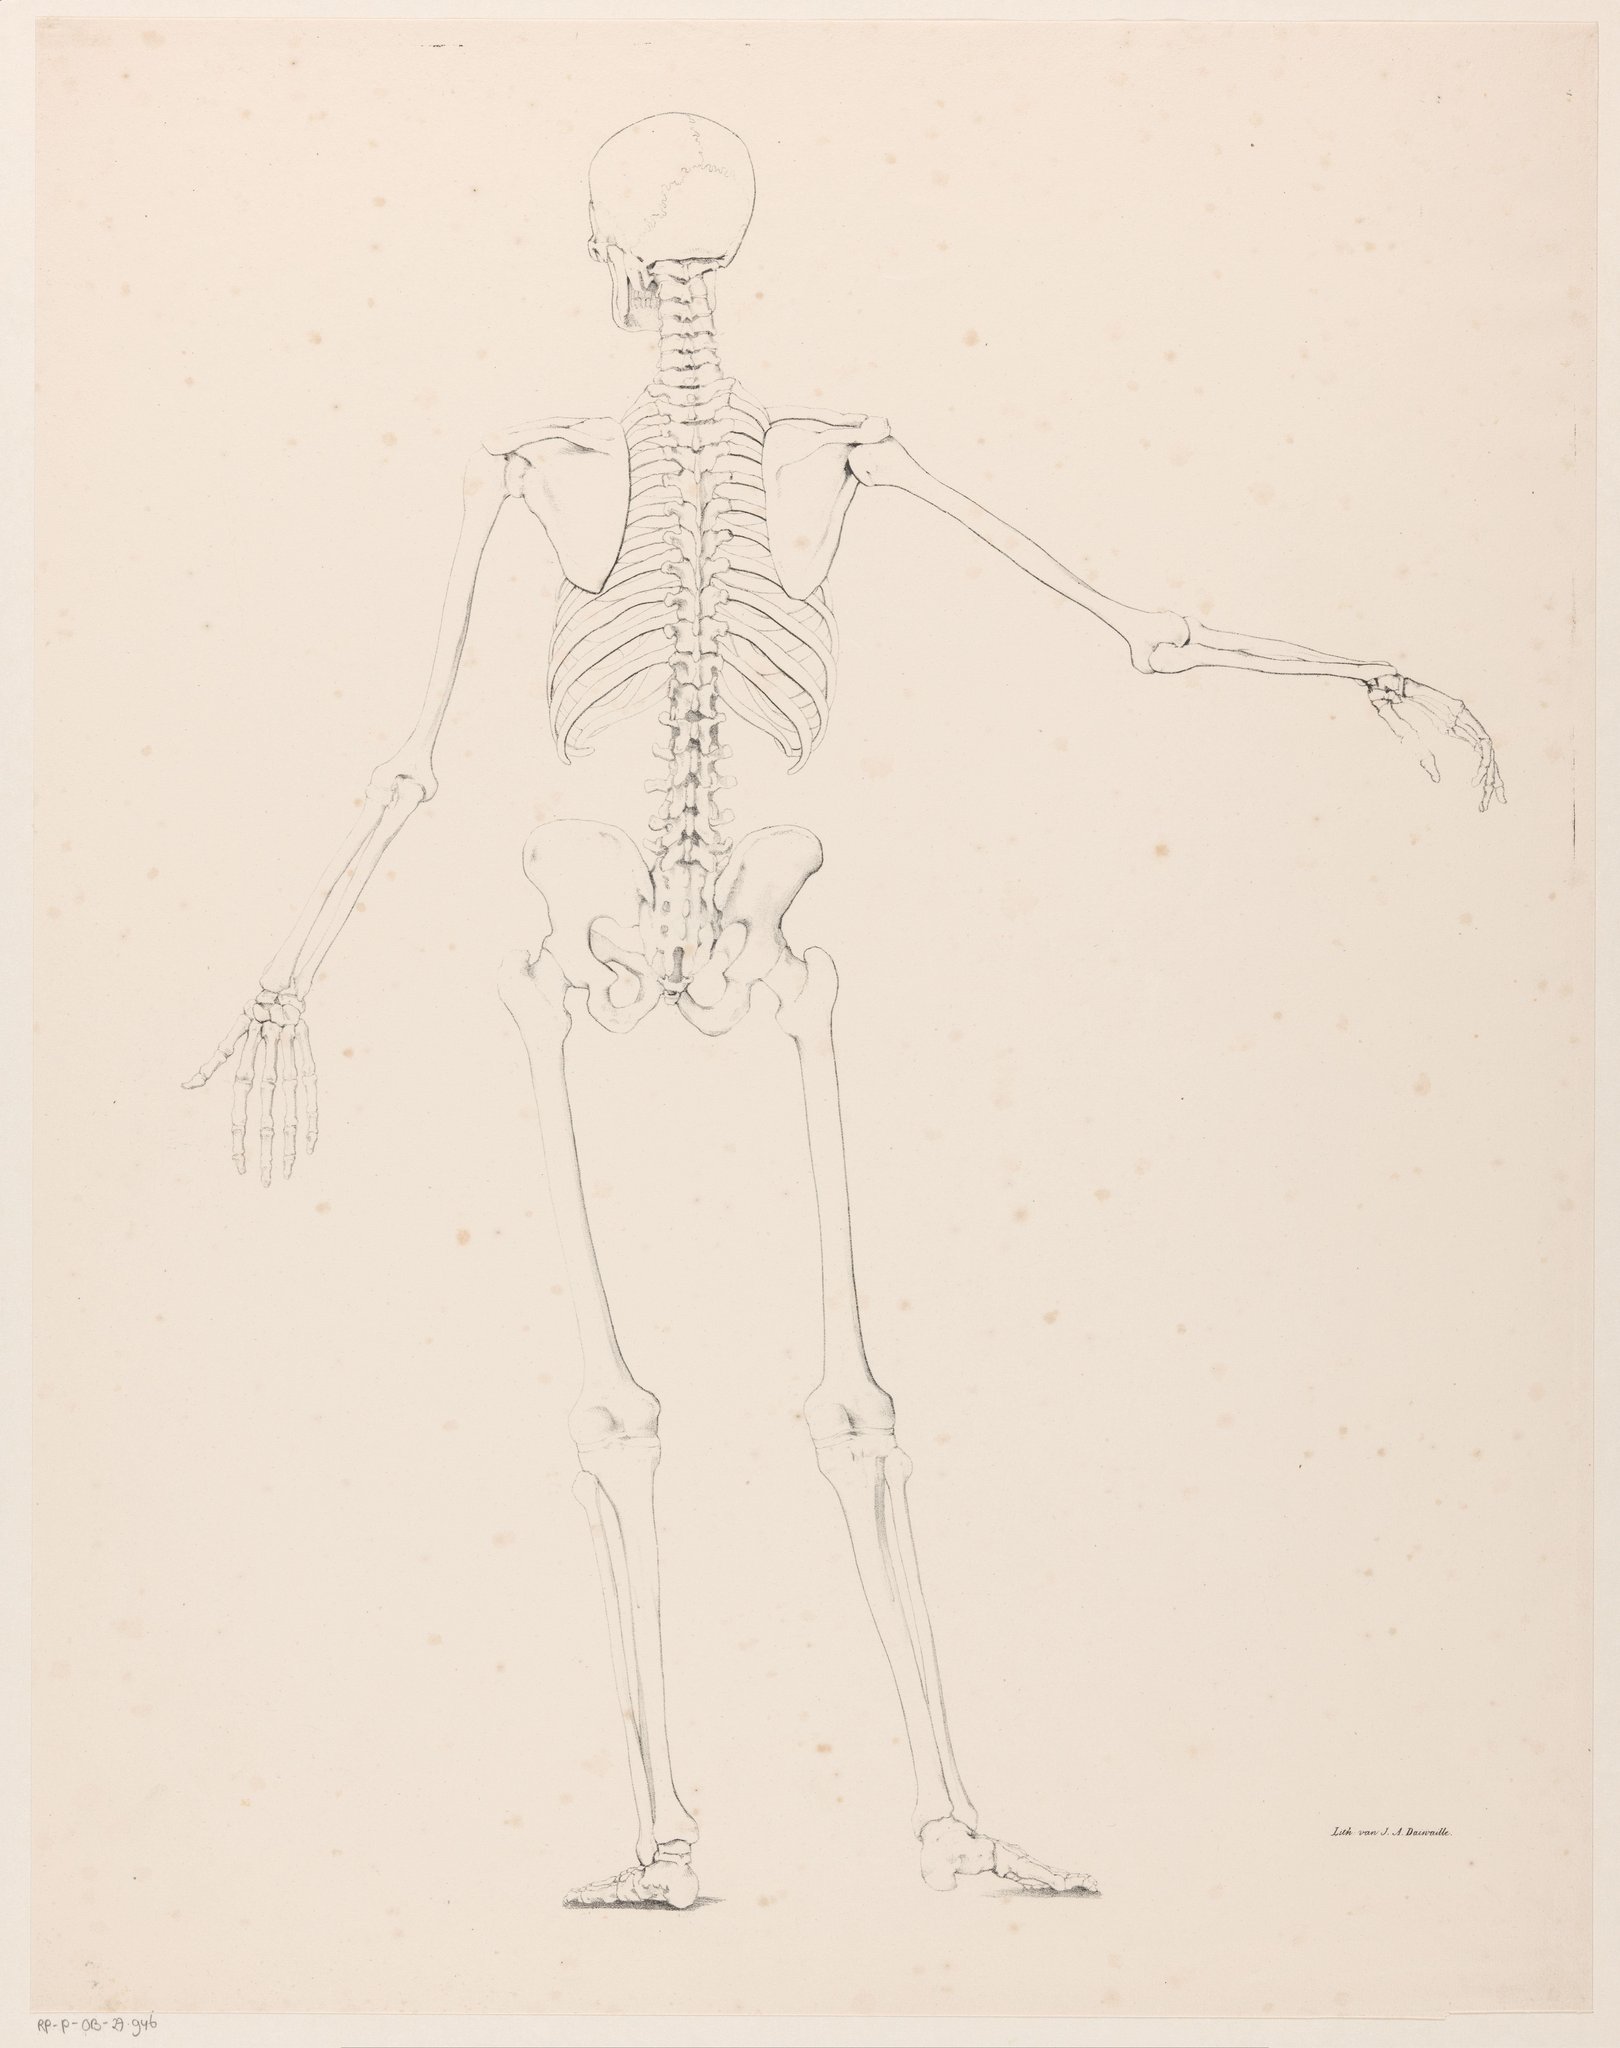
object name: print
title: Menselijk skelet op de rug gezien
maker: jean augustin daiwaille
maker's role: draughtsman, print maker, printer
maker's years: 1786-1850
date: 1820-1833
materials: paper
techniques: lithograph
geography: amsterdam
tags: (human) skeleton (+ back view)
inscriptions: collector's mark: Lugt 2228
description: Het skelet heeft de rechterarm uitgestrekt.